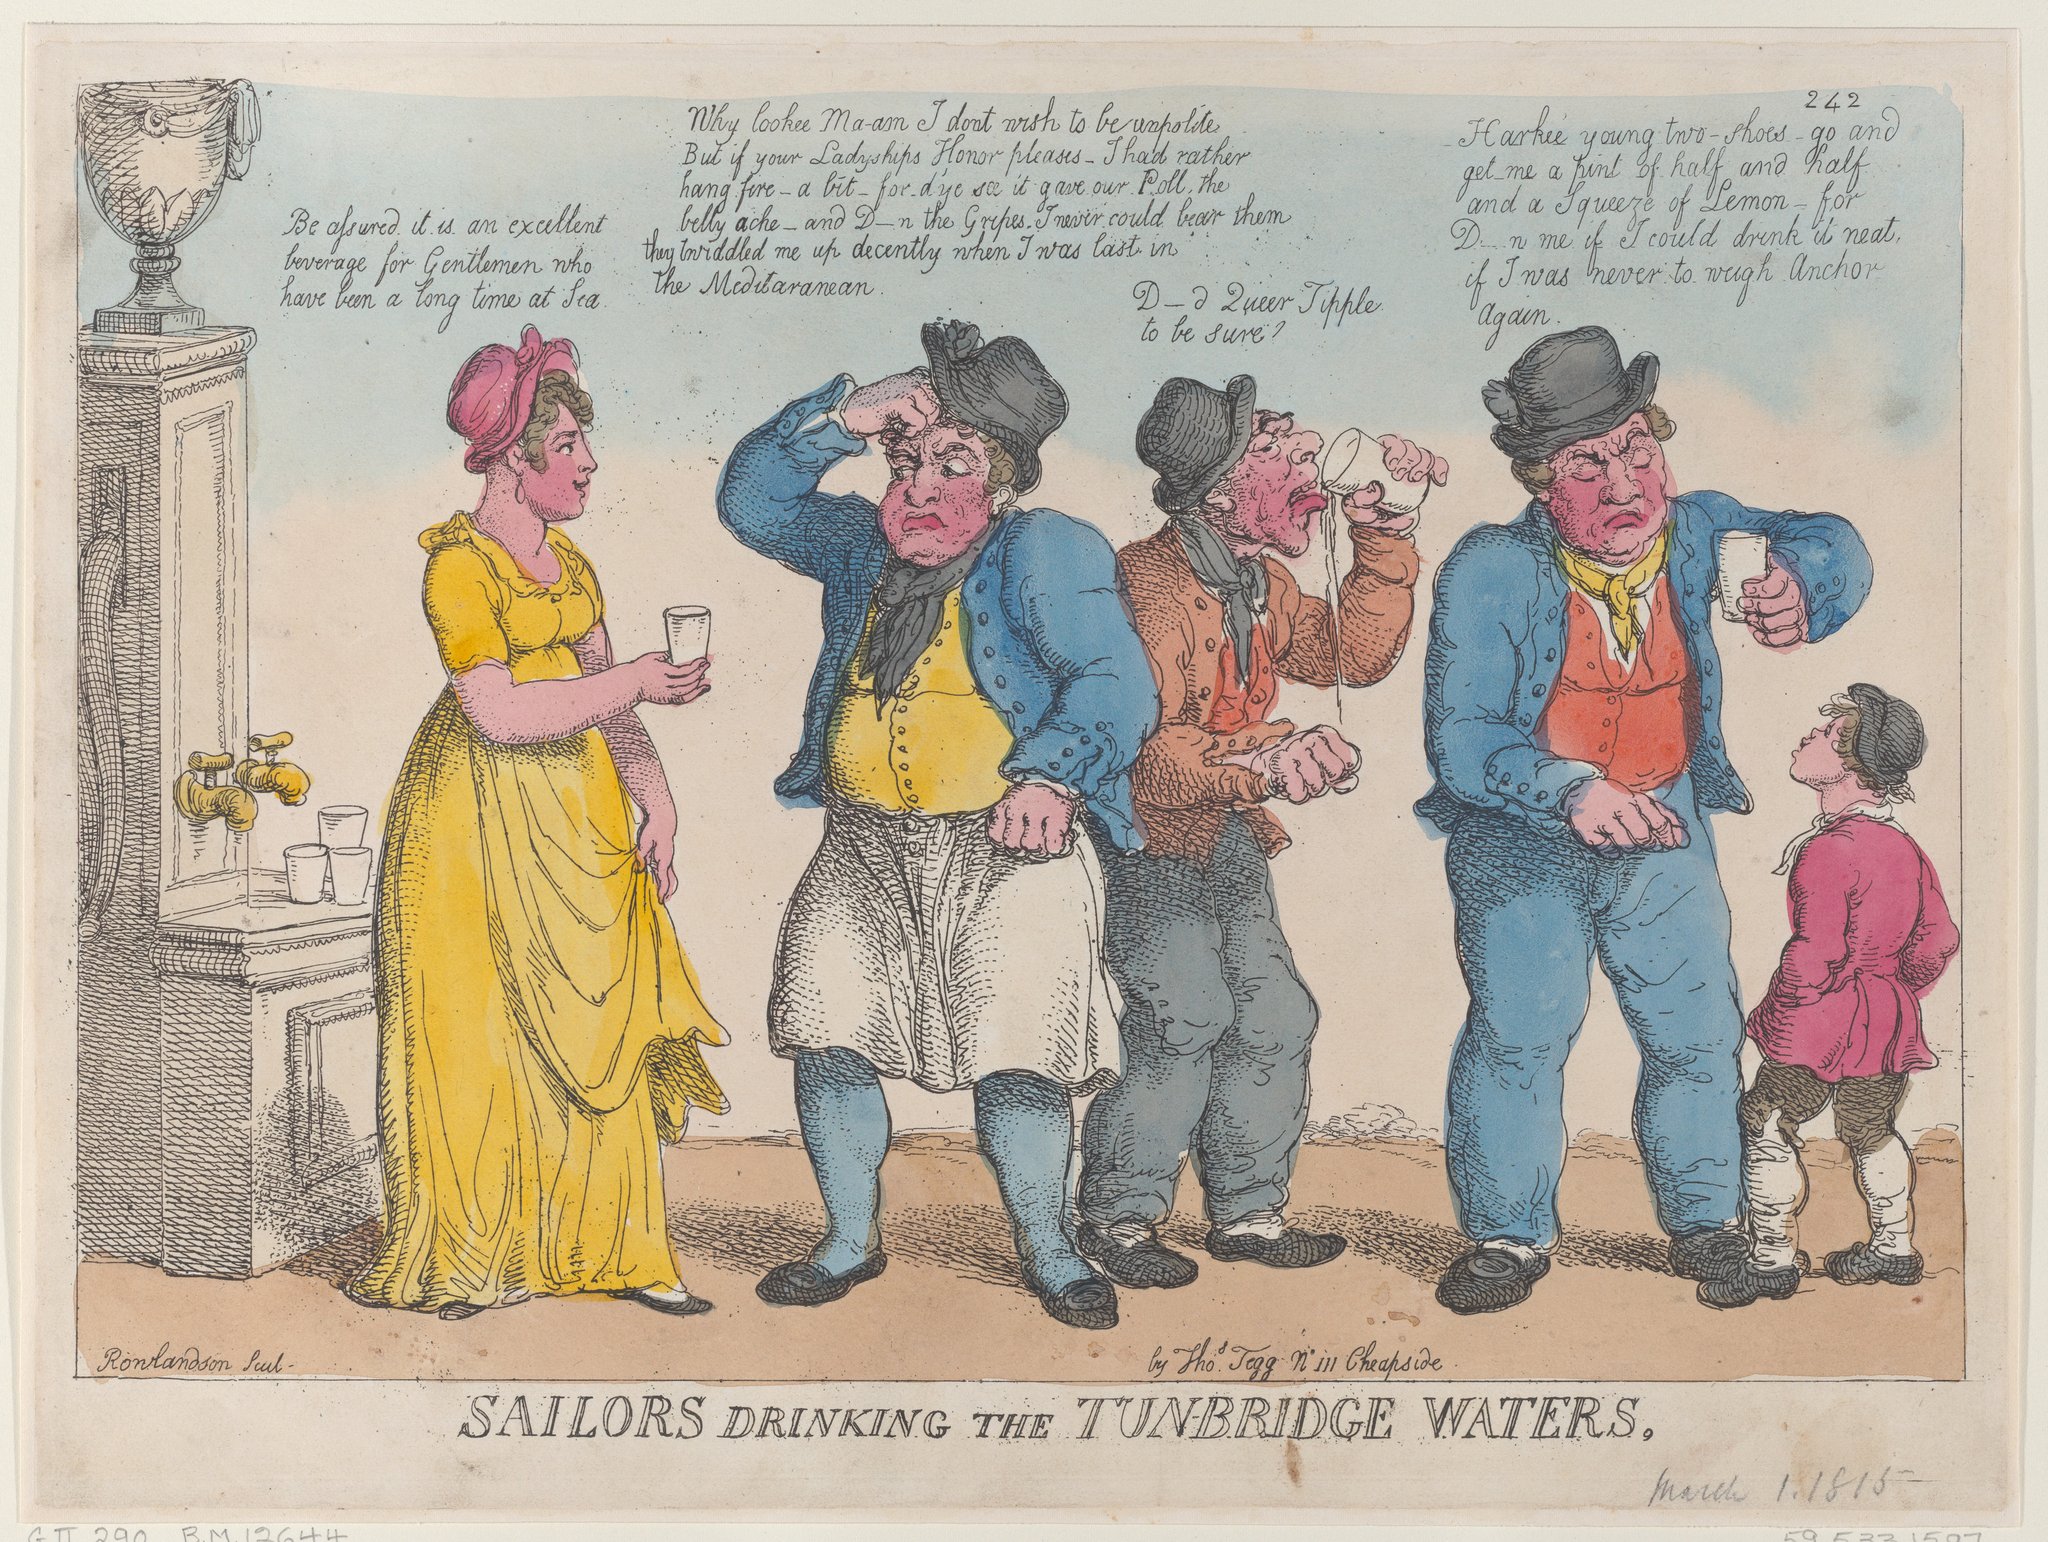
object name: print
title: Sailors Drinking the Tunbridge Waters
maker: thomas rowlandson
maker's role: artist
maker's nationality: british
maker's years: 1757-1827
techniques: etching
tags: satire,men,women,drinking